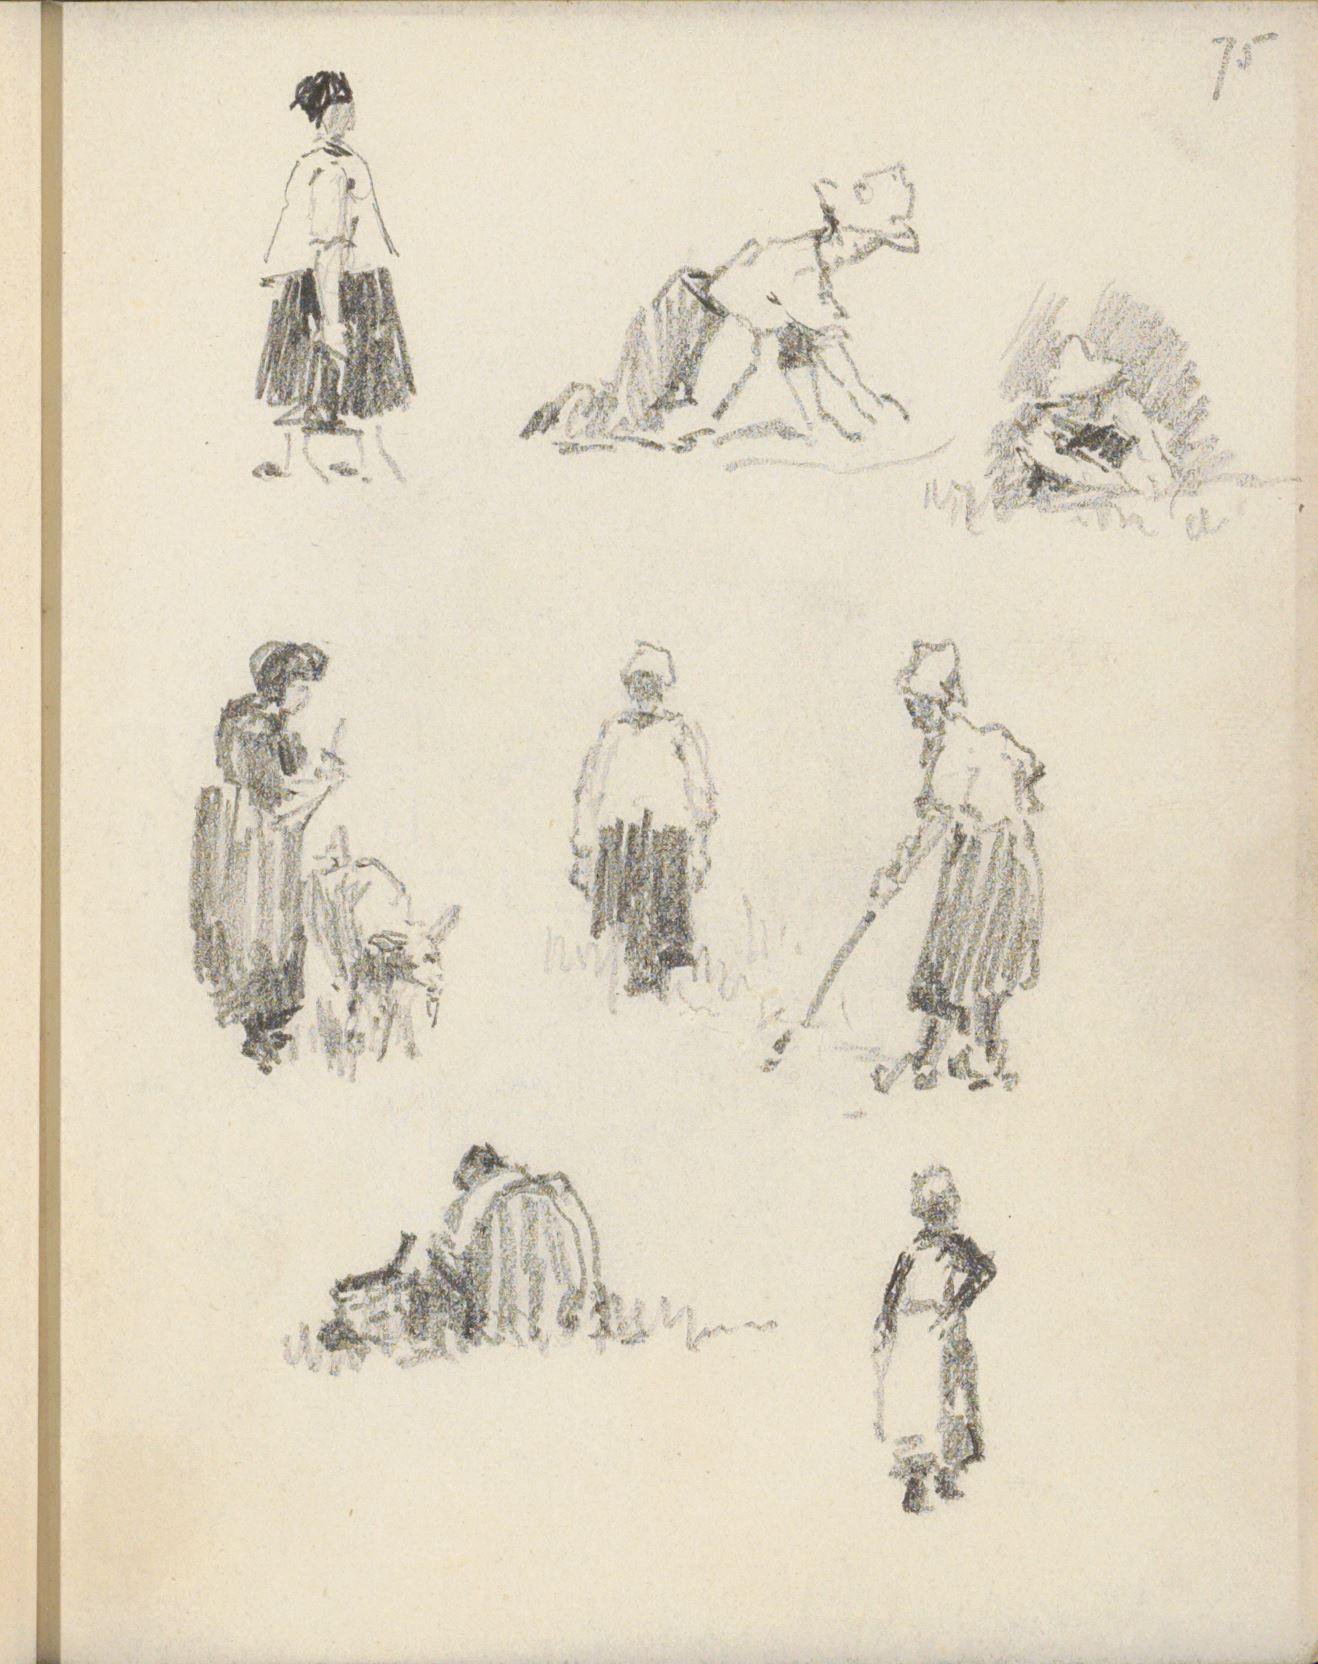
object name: sketchbook leaf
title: Aardappelrooisters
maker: alfred william rich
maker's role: draughtsman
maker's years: 1856-1921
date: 1892-1893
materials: paper, pencil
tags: plants cultivated for their edible roots or tubers, e.g. potato, turnip (+ women (labourers))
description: Blad 75 recto uit een schetsboek met 86 bladen.